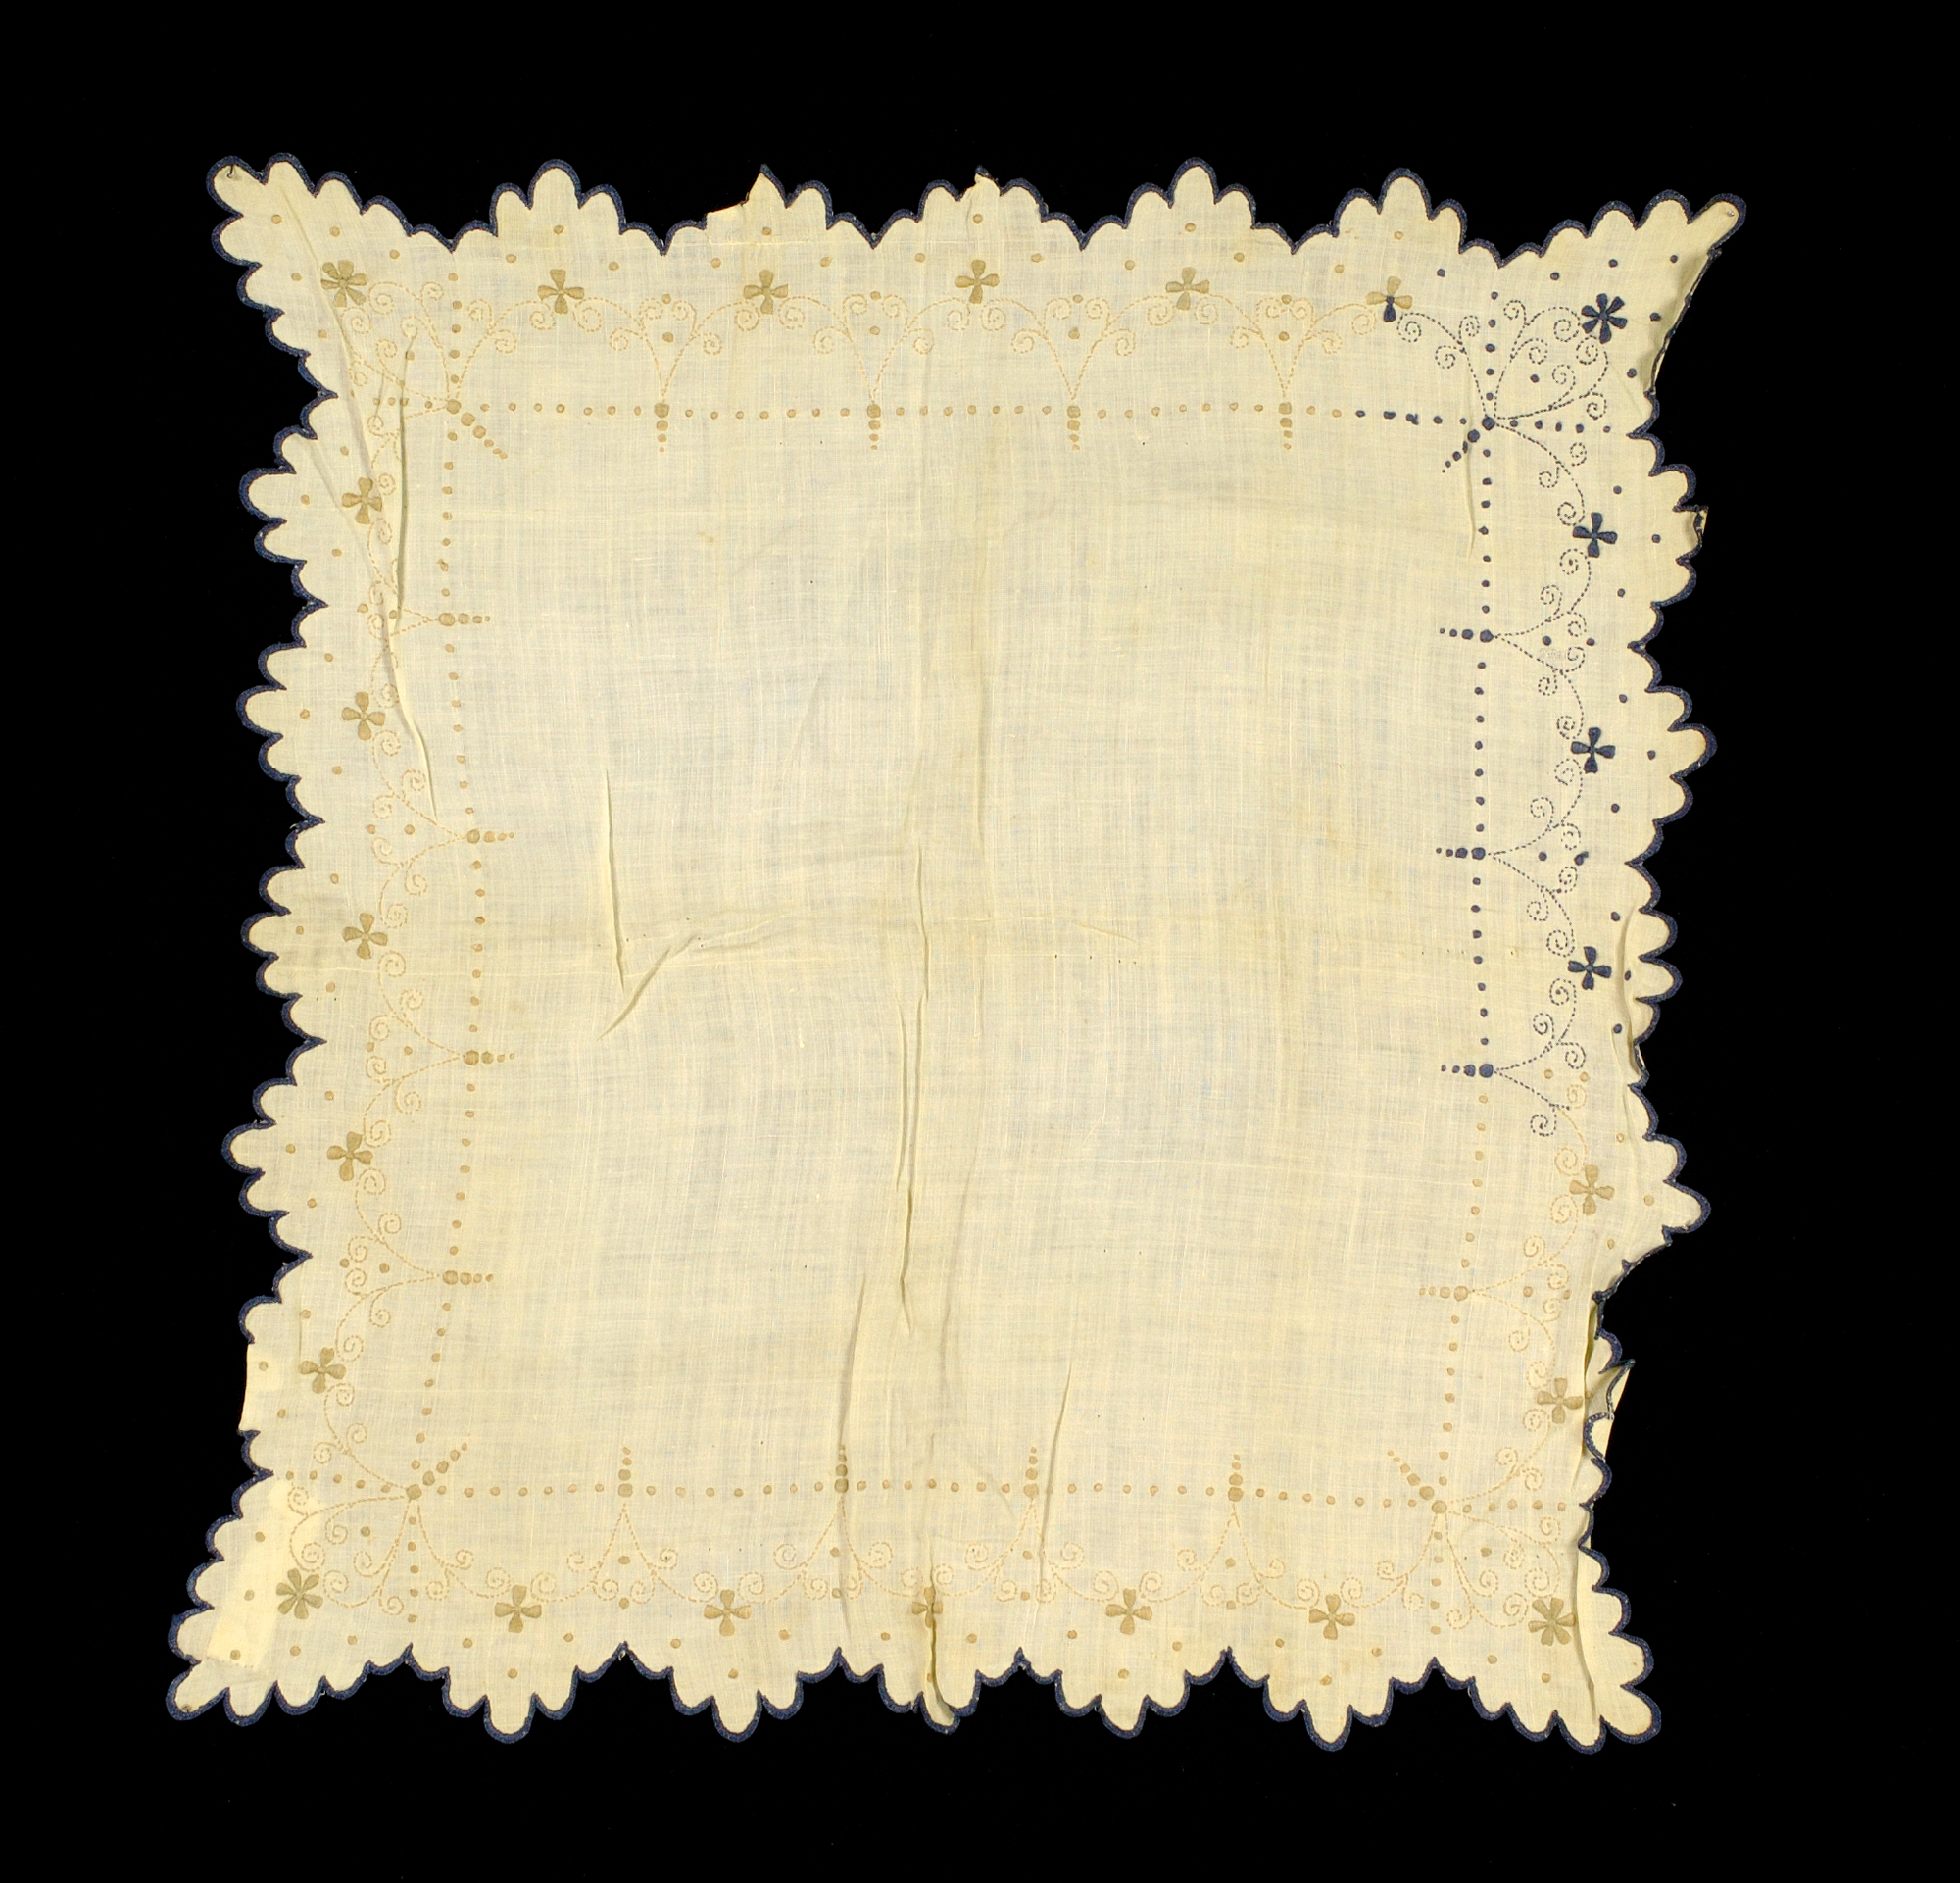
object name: handkerchief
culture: american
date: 1870-1890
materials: linen